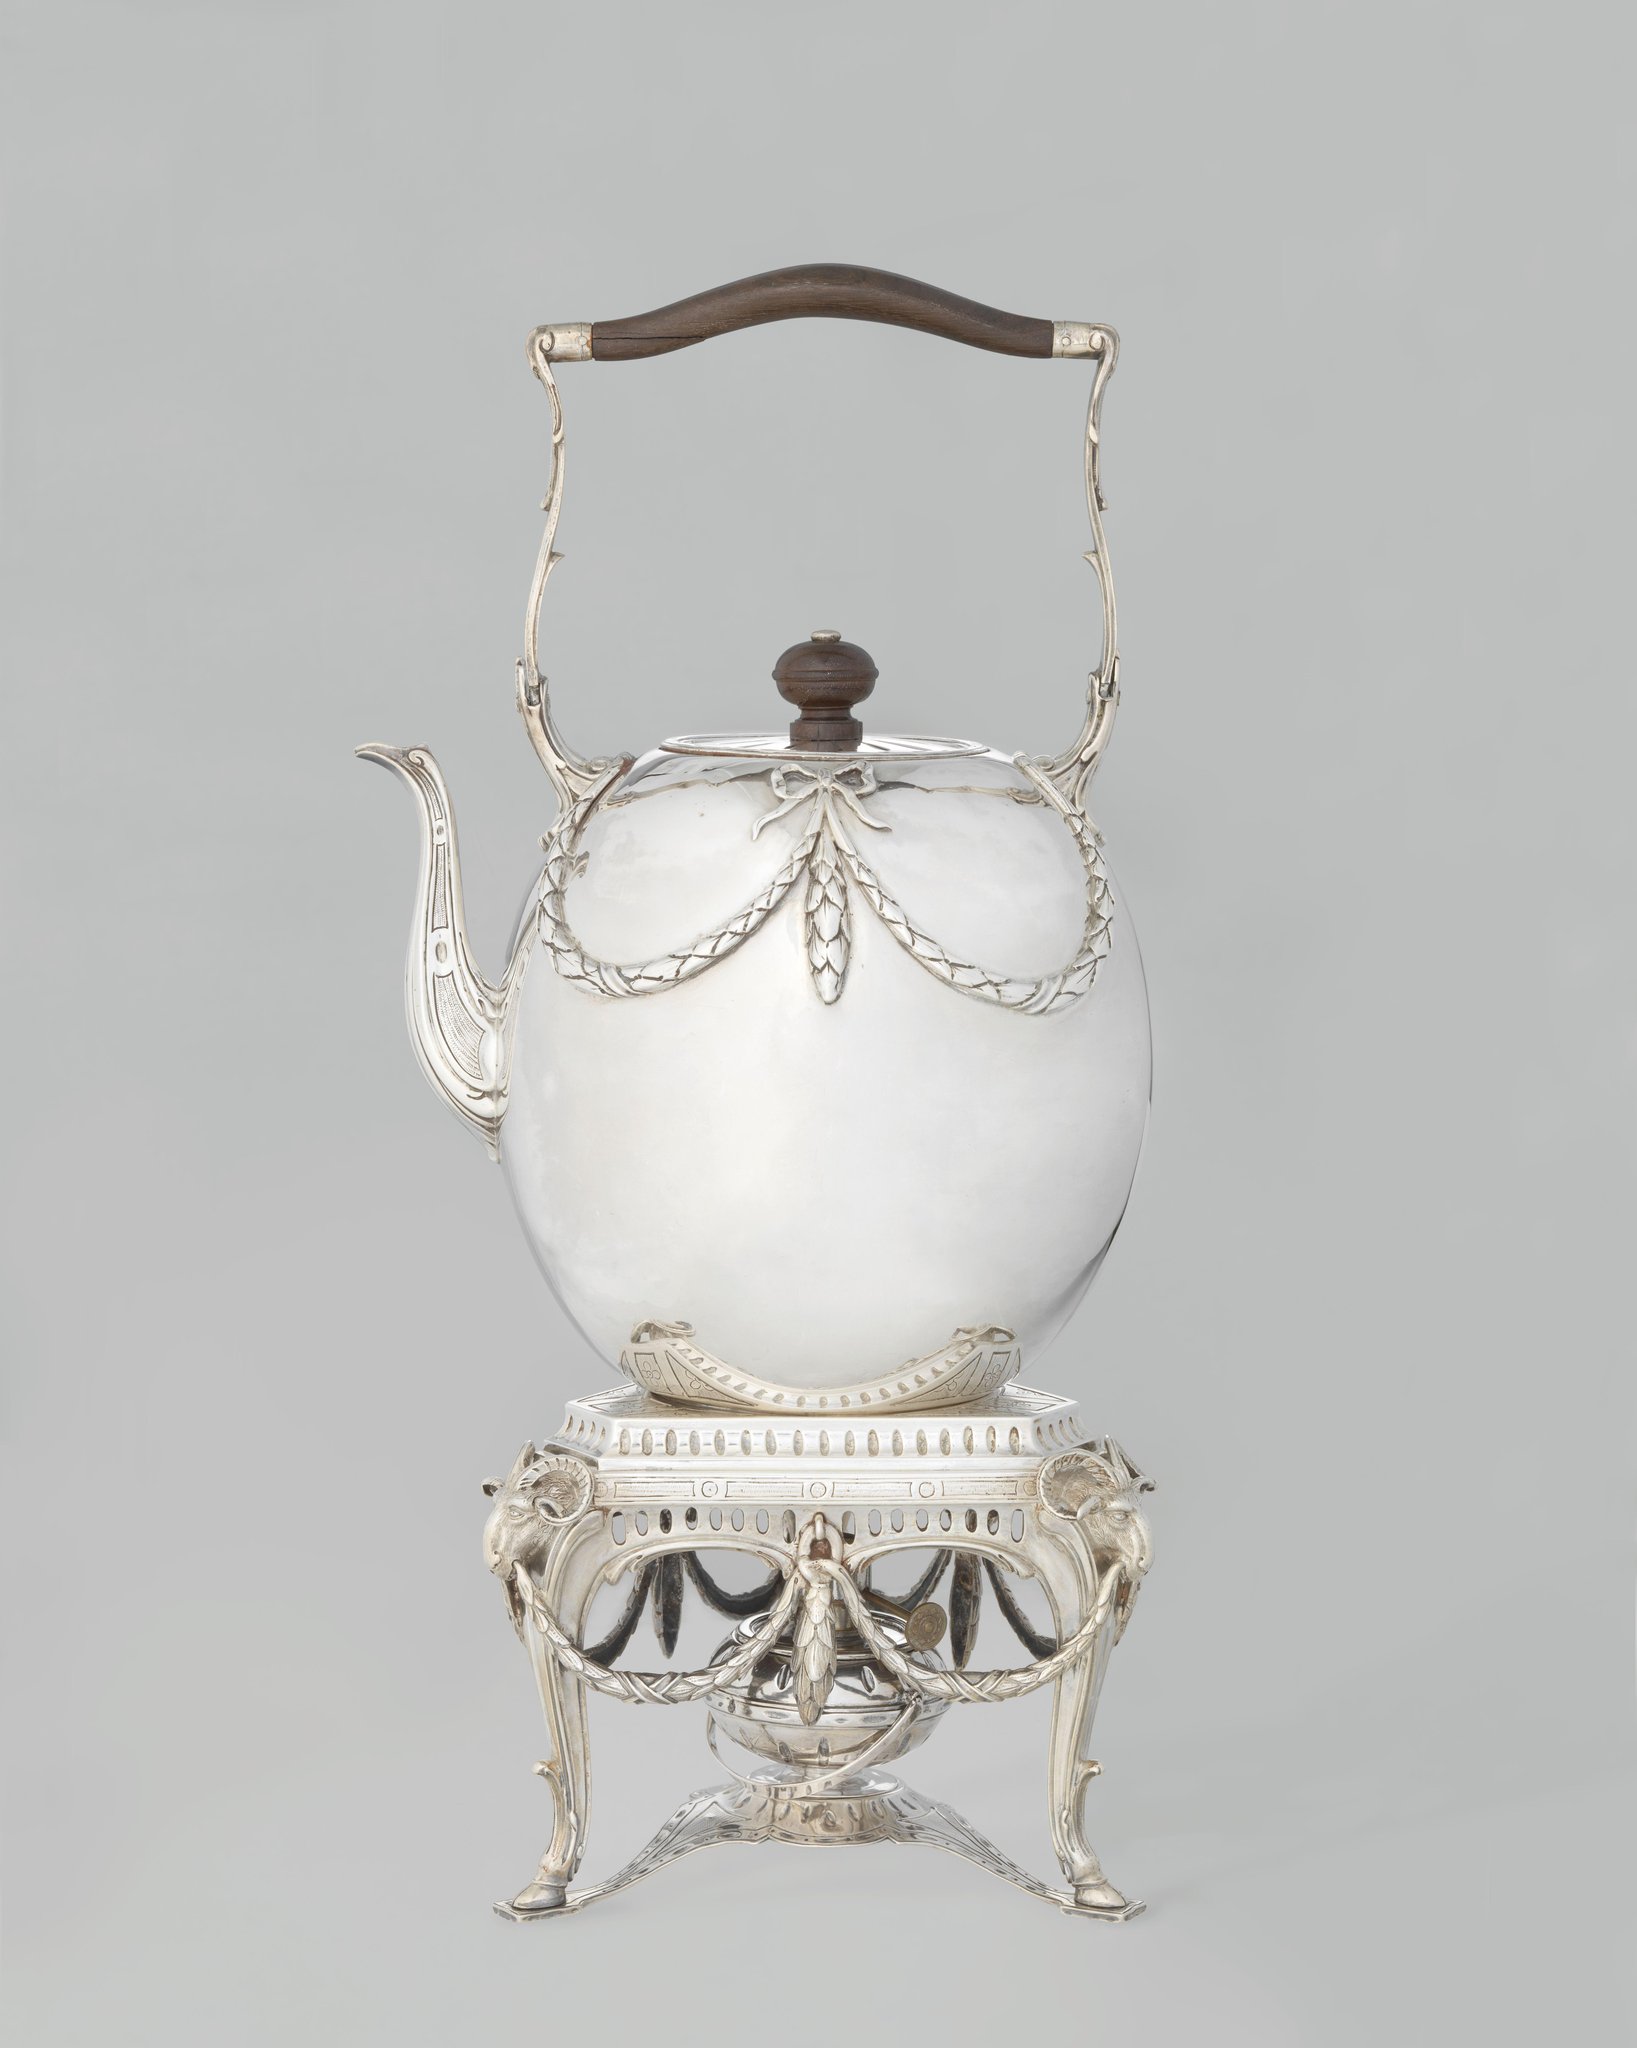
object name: vessel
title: Water kettle on burner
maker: martinus logerath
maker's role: silversmith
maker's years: 1733-1814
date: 1772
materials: wood, silver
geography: amsterdam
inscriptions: town mark, duty mark, alloy mark, : ‘L’, maker's mark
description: Het deksel wordt omgeven door een verhoogde, geprofileerde rand met een versiering van verdiepte ovalen. Rond de geprofileerde, bolvormige knop, die bekroond wordt door een zilveren knopje, is straalsgewijs een versiering van druppelvormen aangebracht.